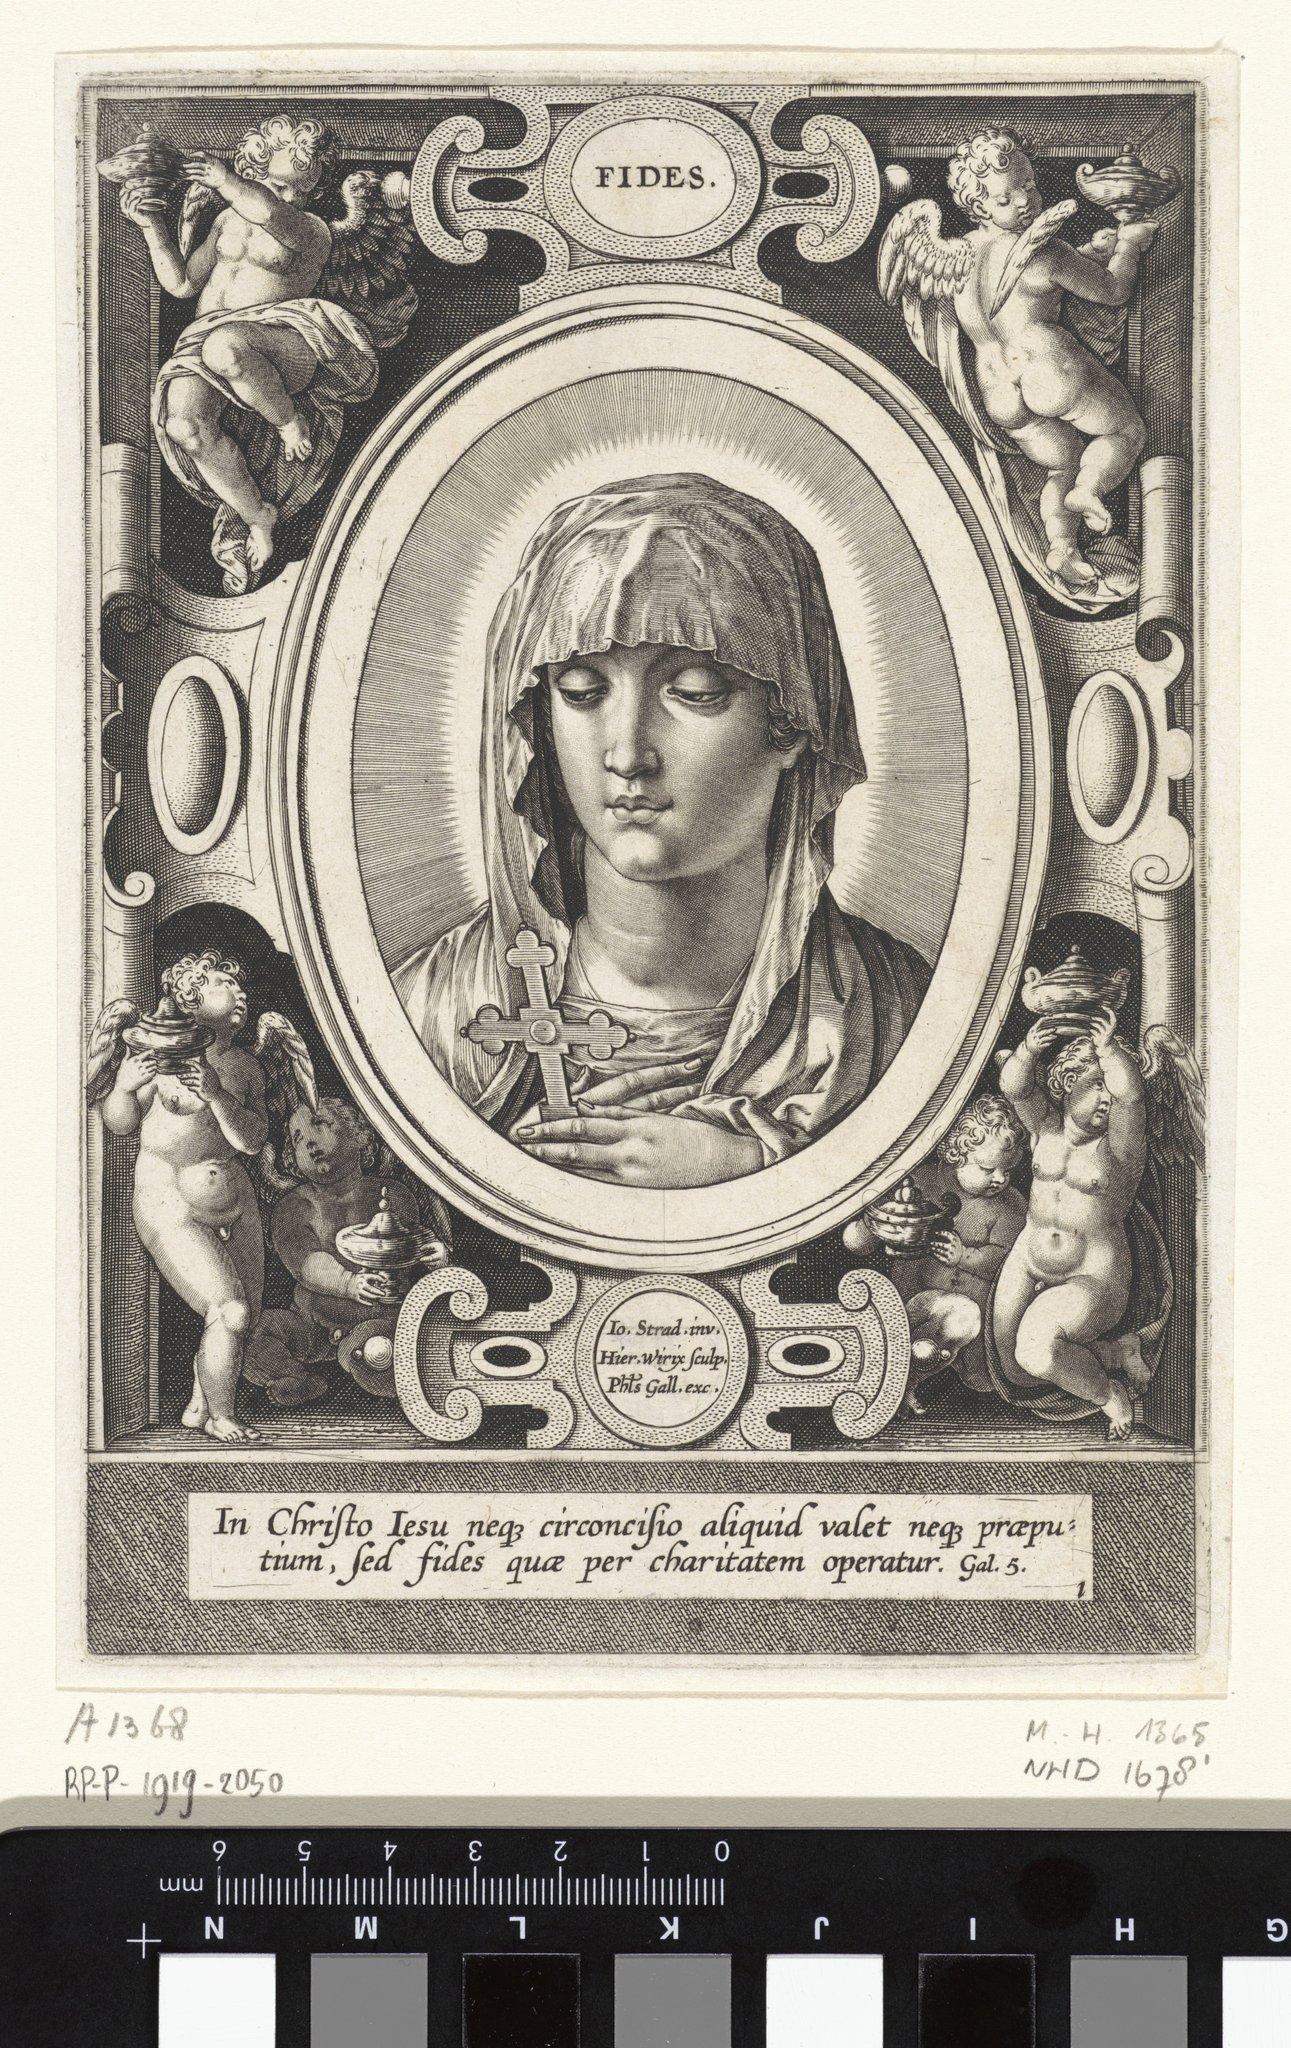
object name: print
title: Geloof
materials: paper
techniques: engraving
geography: antwerp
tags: faith, 'fides'; 'fede', 'fede catholica', 'fede christiana', 'fede christiana catholica' (ripa) ~ one of the three theological virtues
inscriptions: collector's mark: Lugt 2233, collector's mark: Lugt 2542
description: Buste van de vrouwelijke personificatie van Geloof. Ze is gesluierd en houdt een kruis in de handen. De voorstelling is gevat in een cartouche, omringd door putti. In het kader in de marge een tweeregelig Bijbelcitaat uit Gal. 5 in het Latijn.